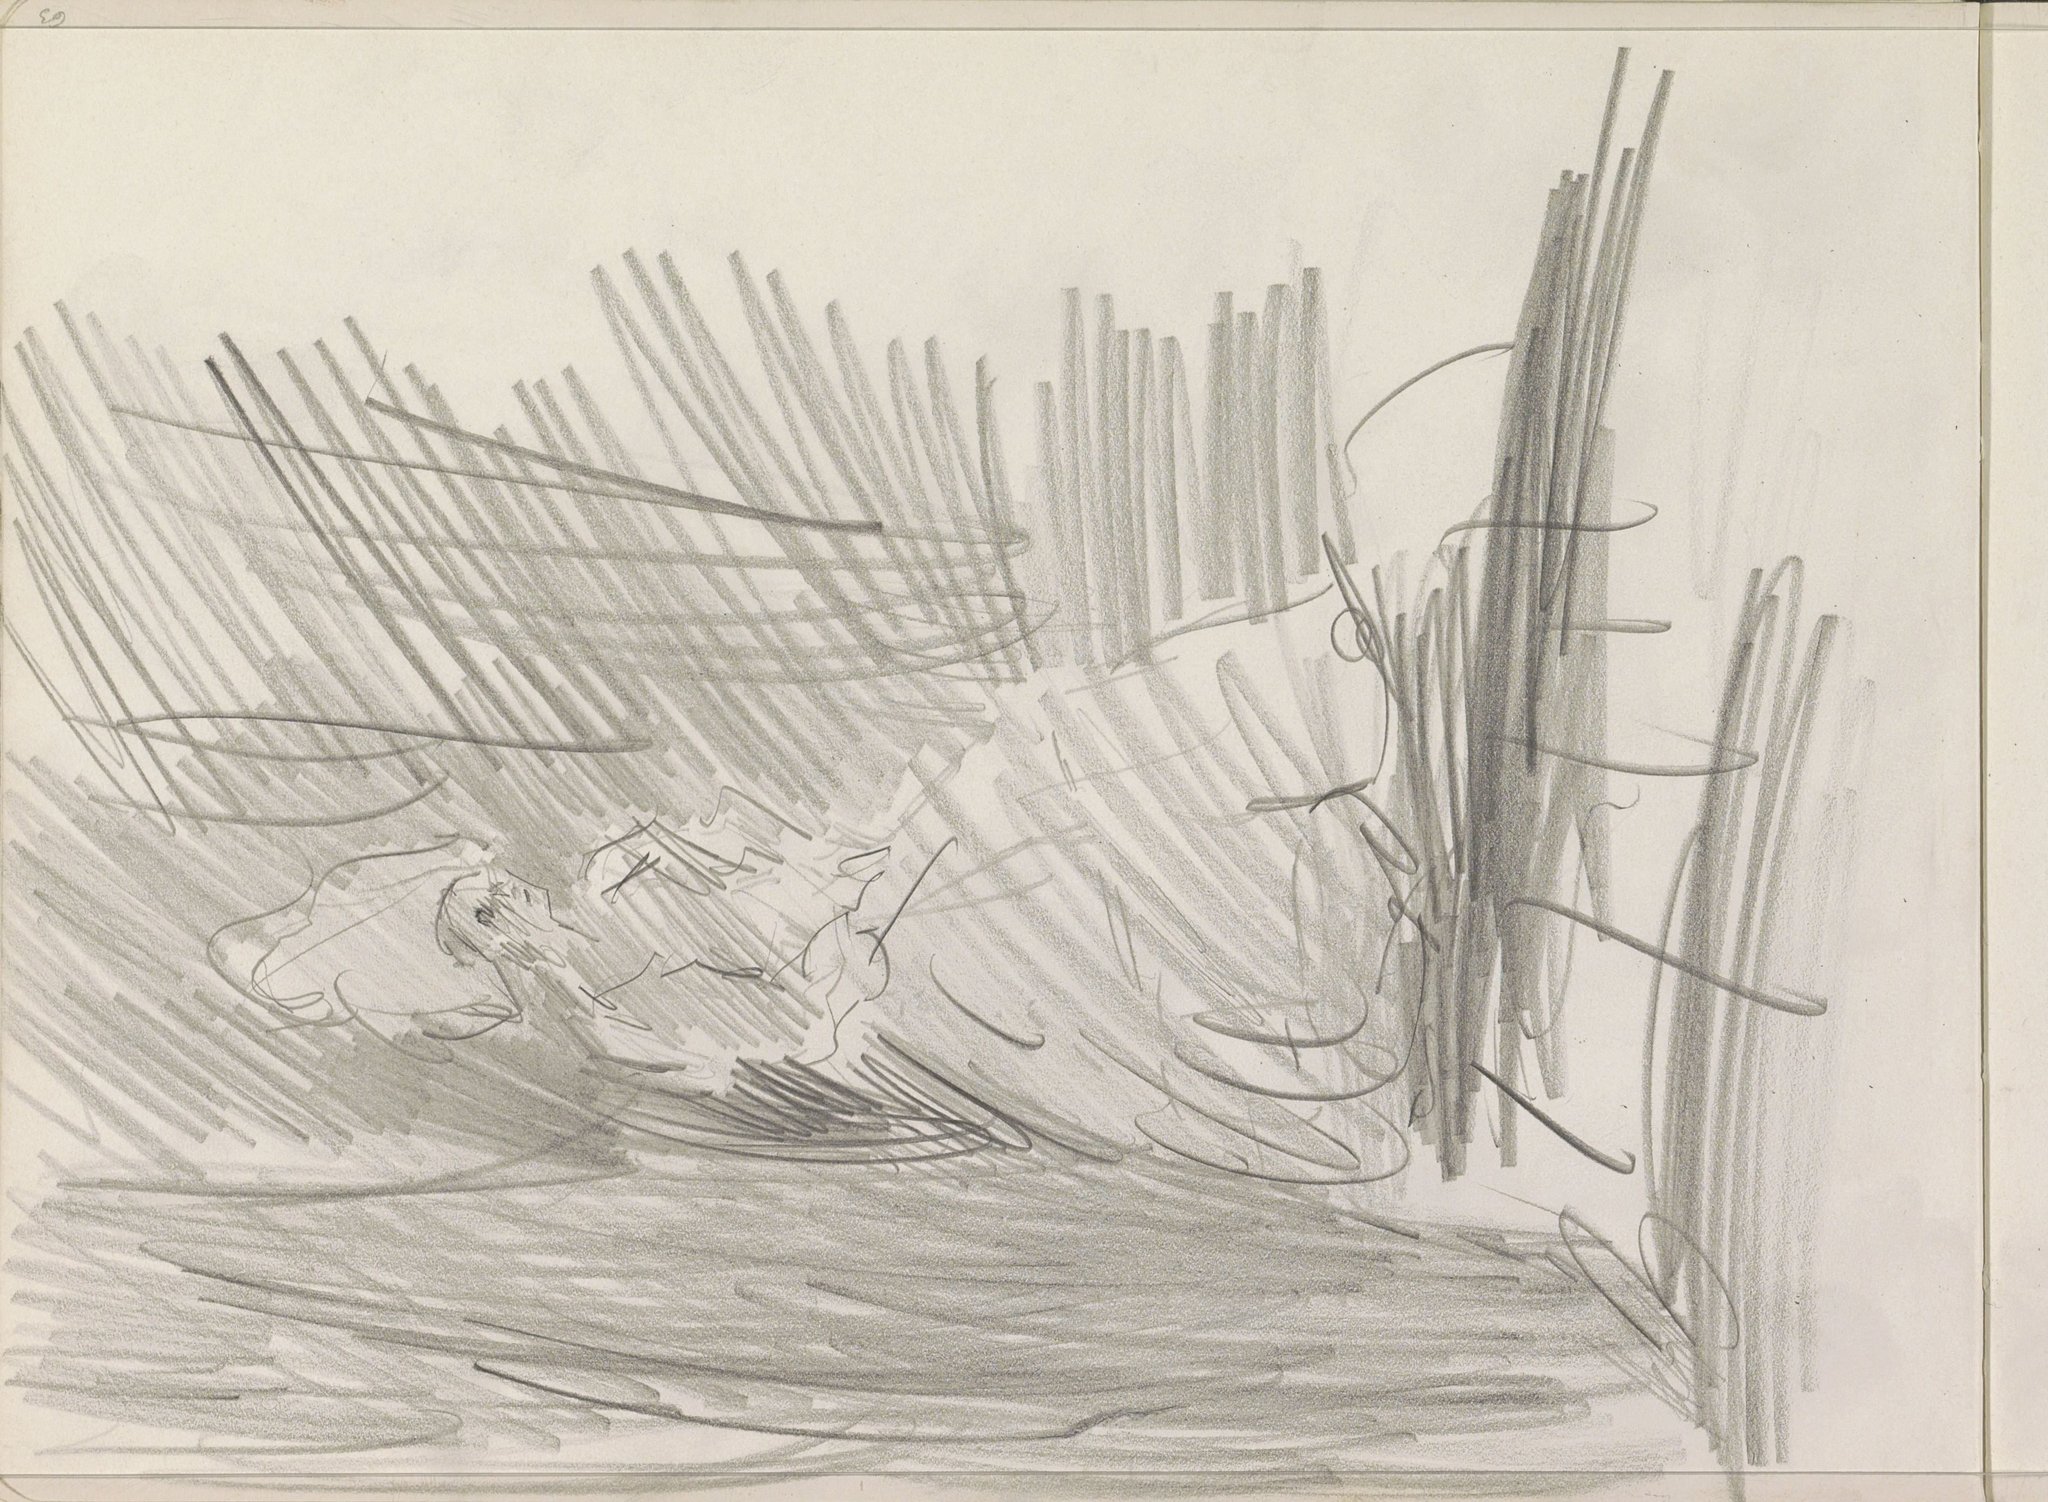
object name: sketchbook leaf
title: Staande vrouw in een lange jurk, mogelijk een danseres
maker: isaac israels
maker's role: draughtsman, painter, print maker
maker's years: 1865-1934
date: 1915-1934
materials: paper, pencil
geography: the hague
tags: female dancer, standing figure - aa - female human figure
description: Met een hoed of hoofdtooi. Ze staat in een interieur, mogelijk in de coulissen. Met een Blad 10 verso uit schetsboek III met 36 bladen.